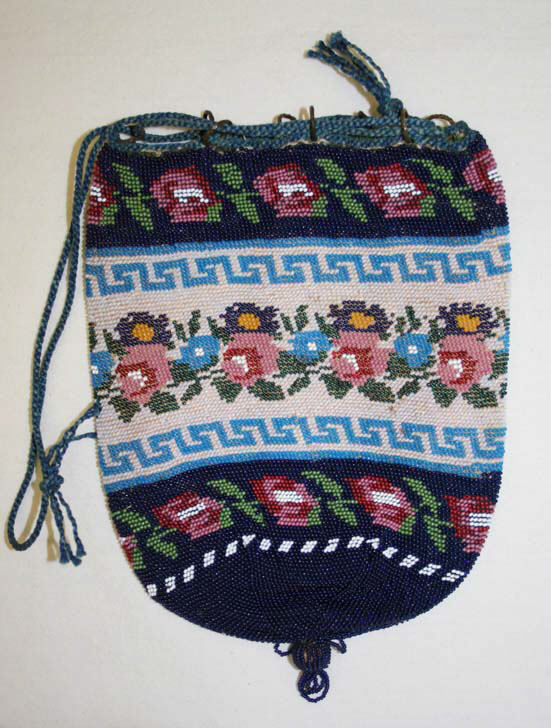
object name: reticule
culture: american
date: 1840-1850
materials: glass, silk